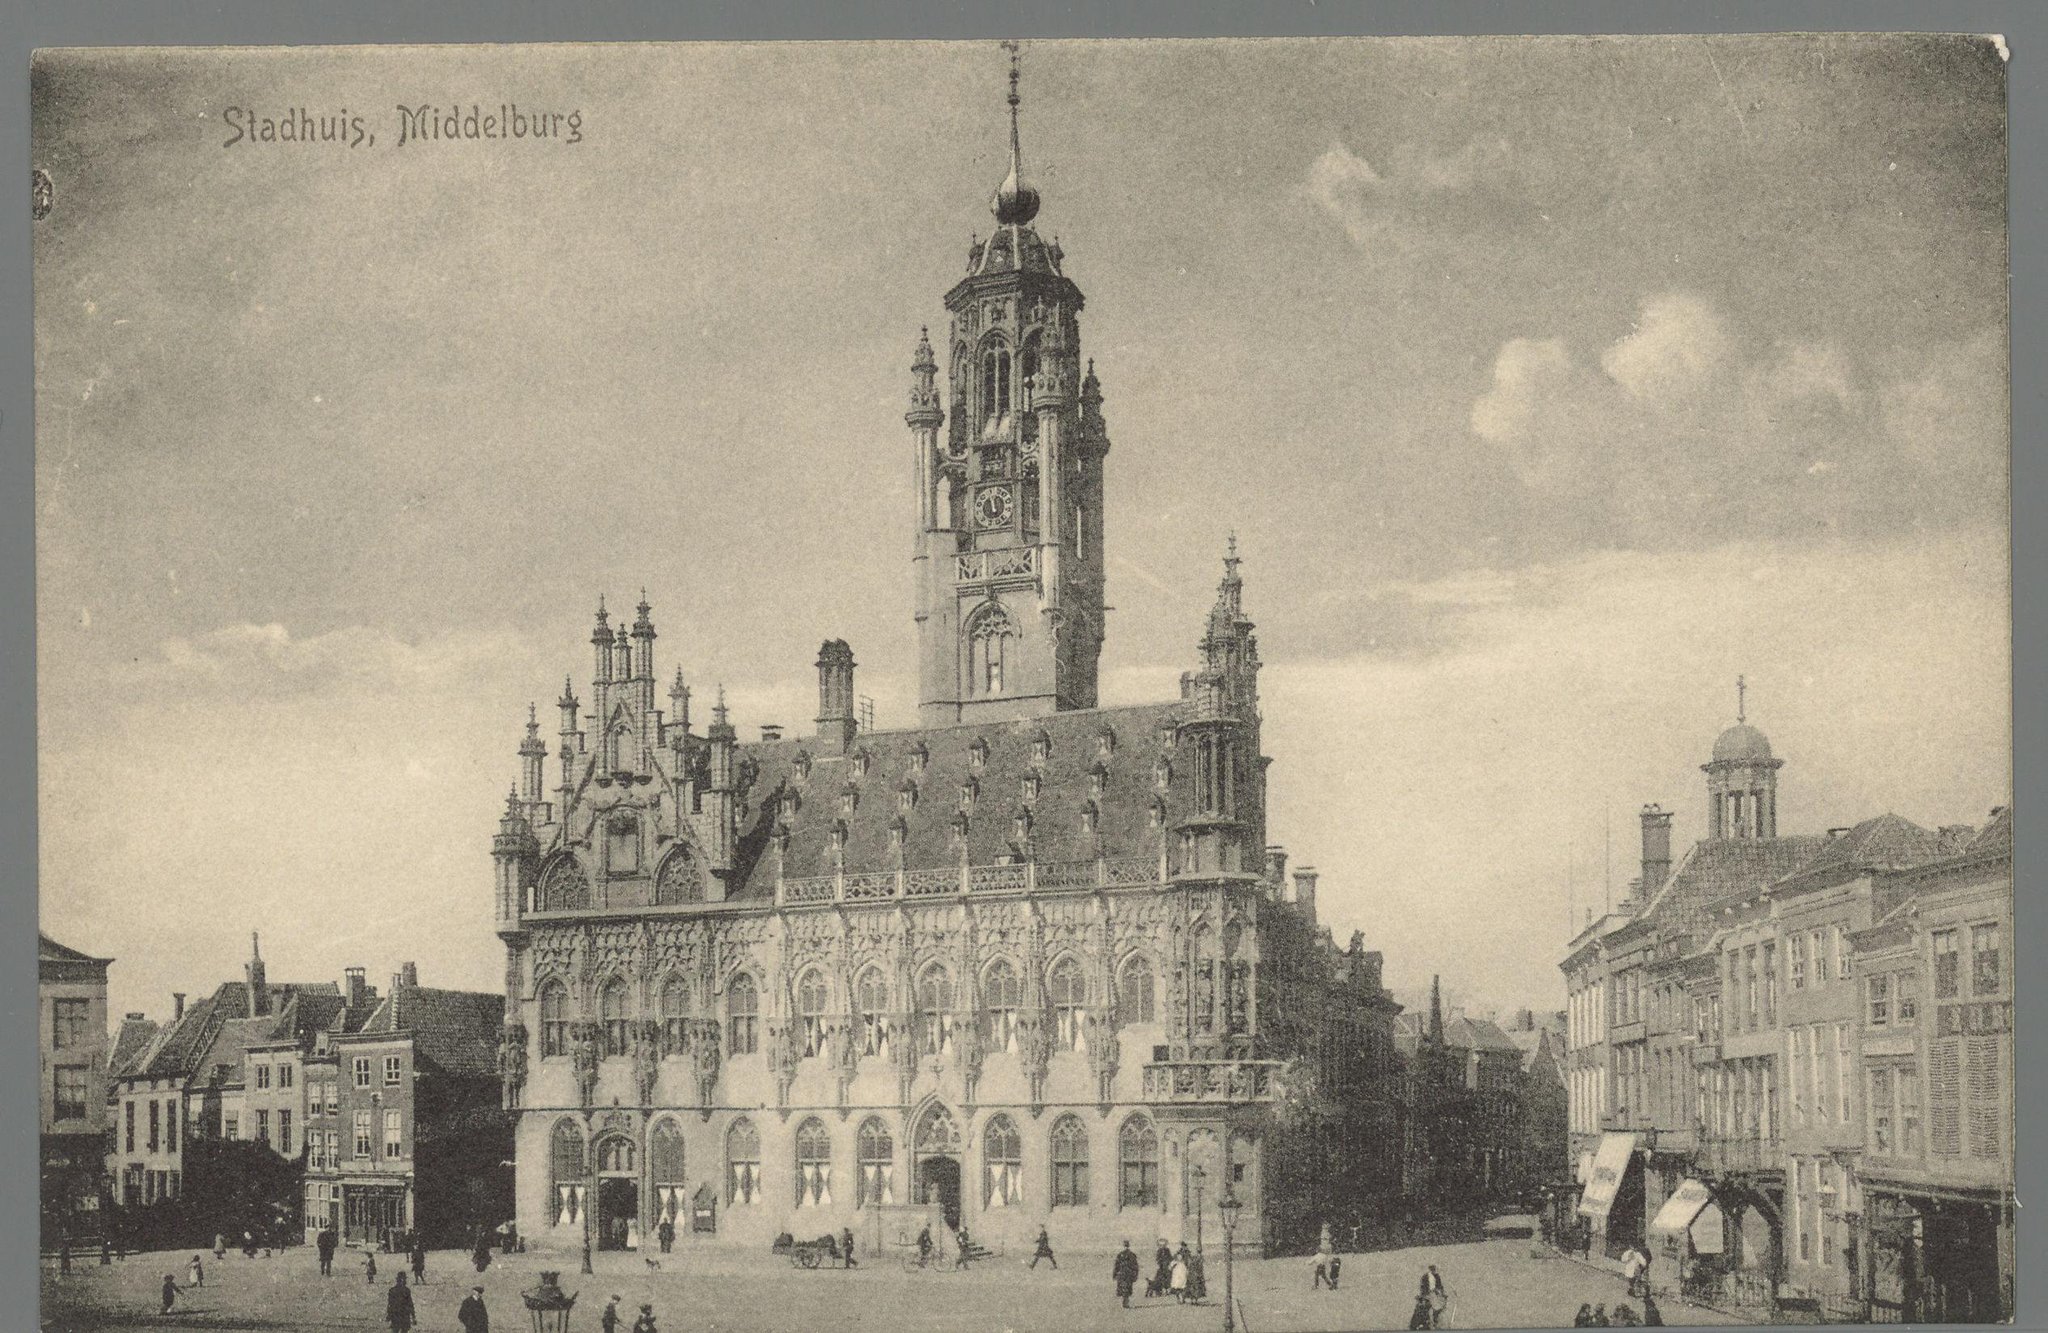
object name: ansichtkaart, prentbriefkaart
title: Stadhuis, Middelburg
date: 1905-1930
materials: cardboard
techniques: photograph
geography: middelburg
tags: city-view, and landscape with man-made constructions, townhall